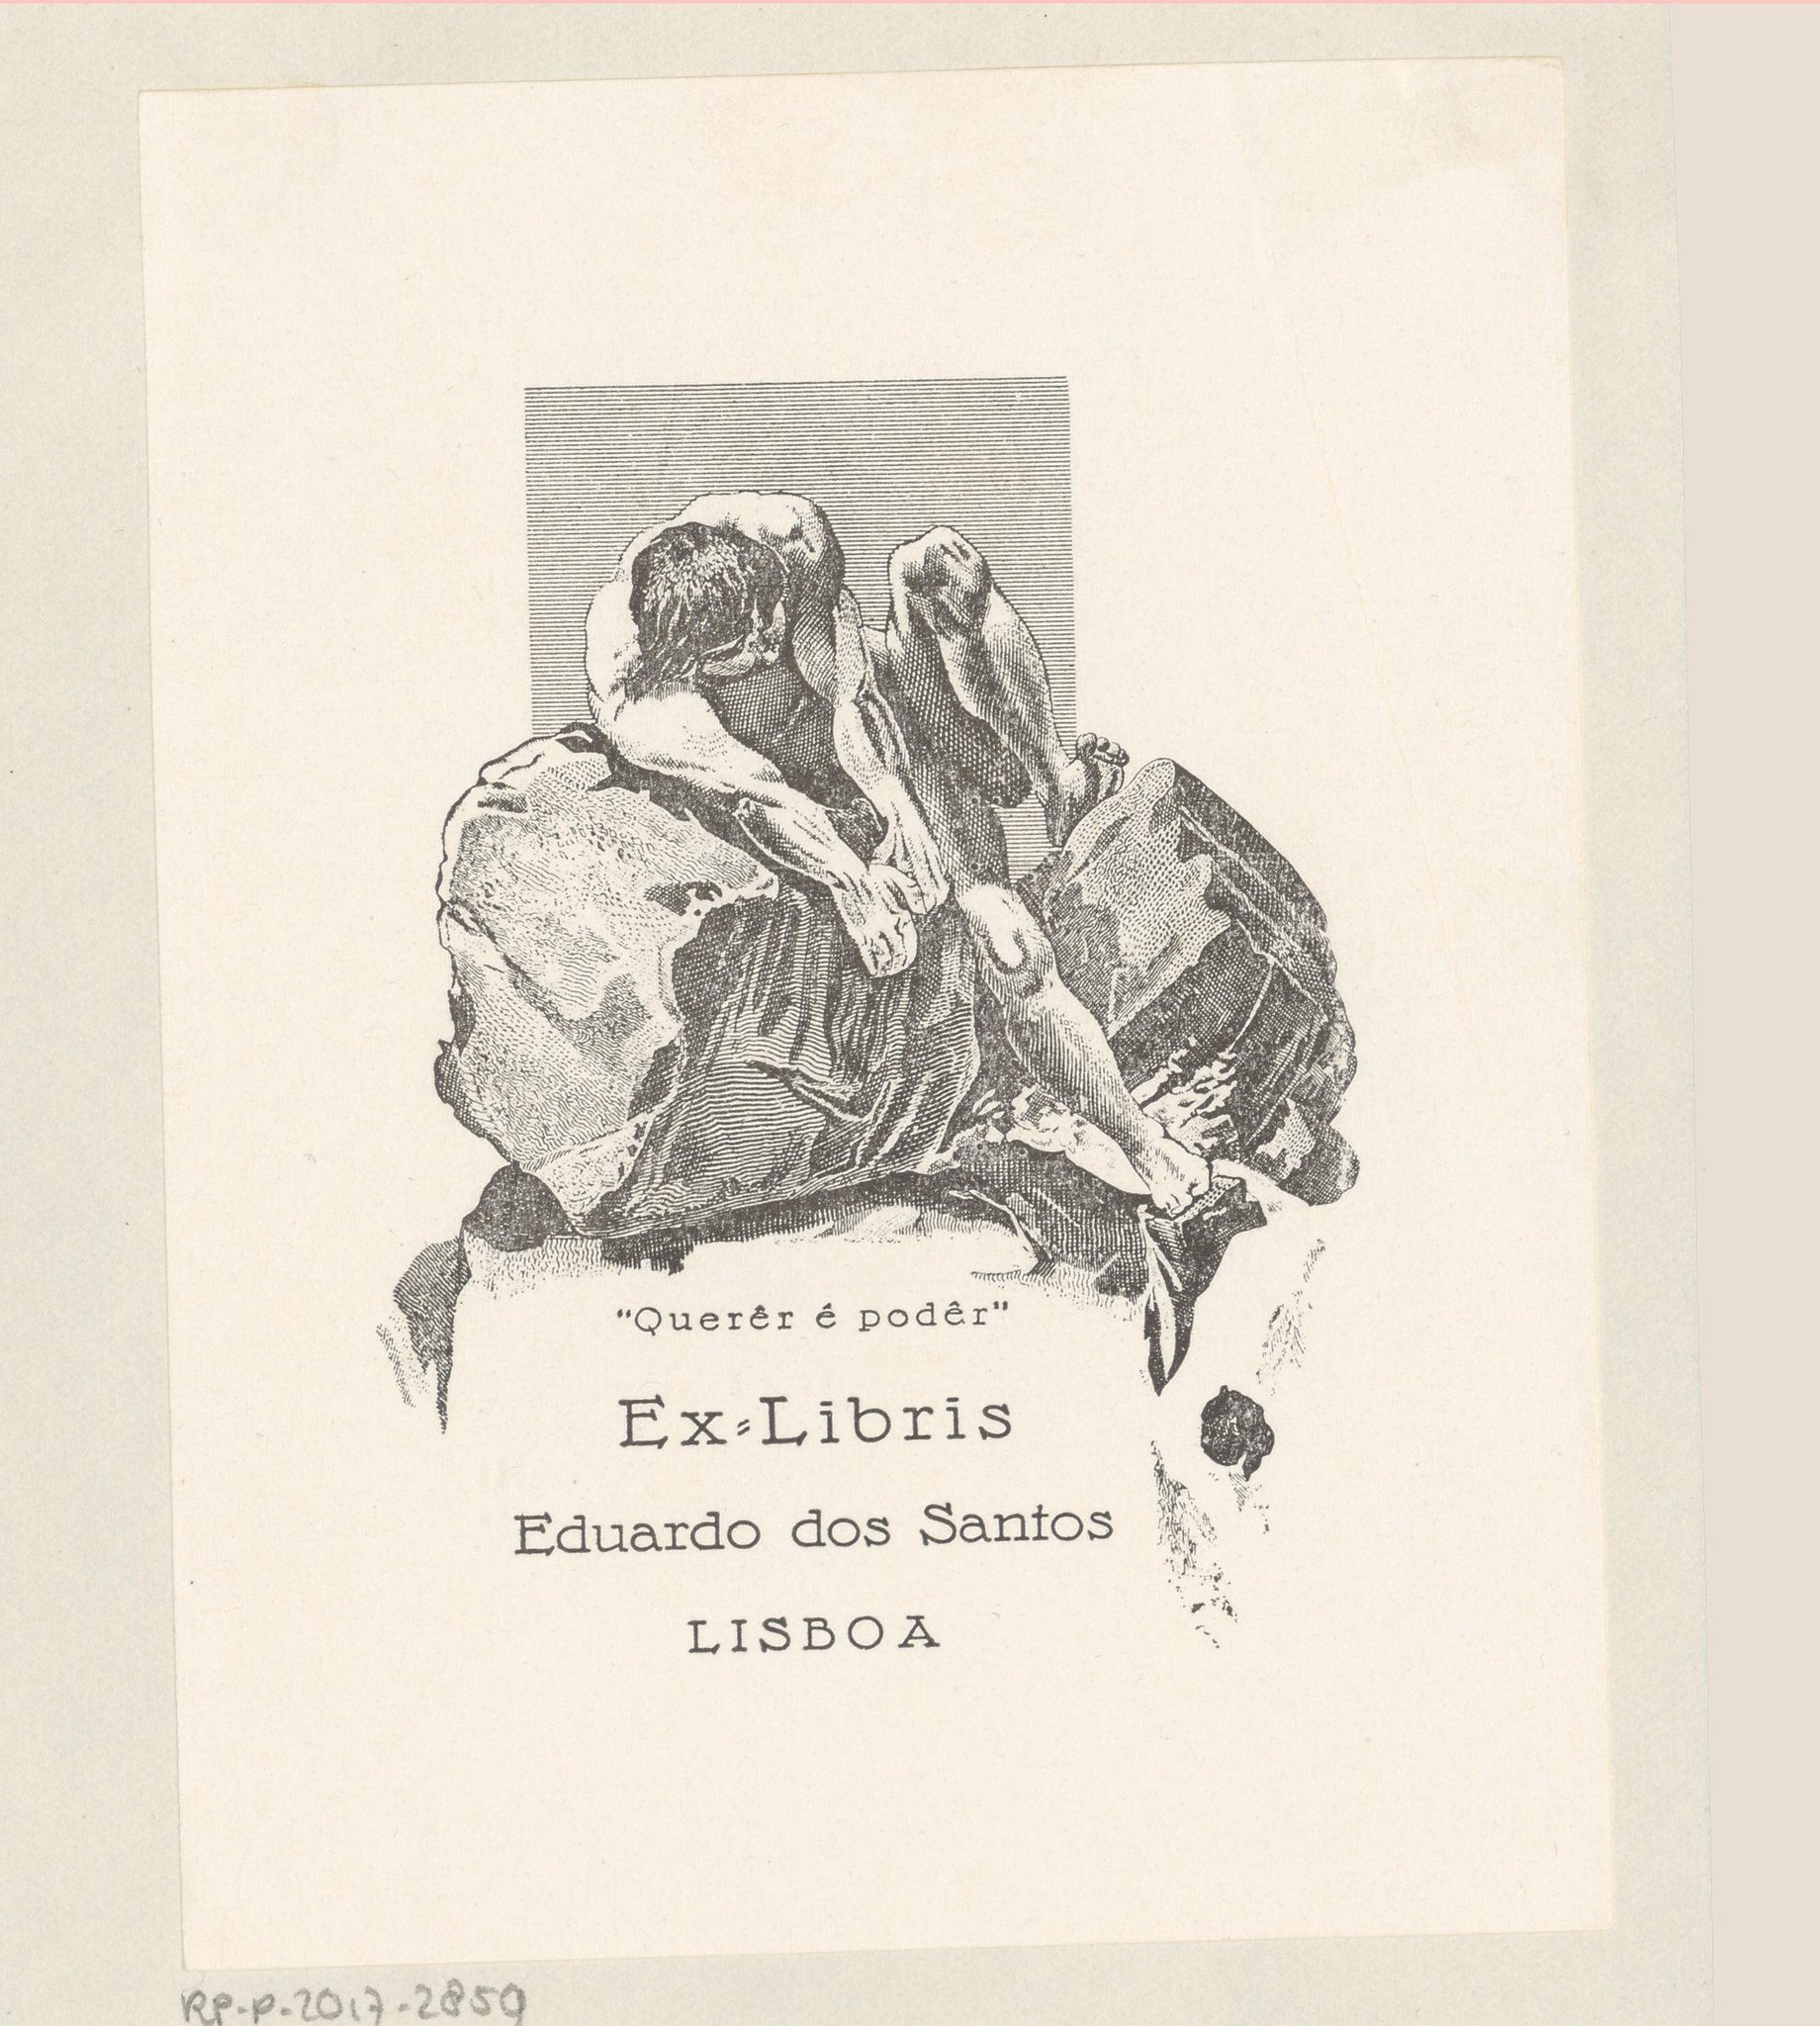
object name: bookplate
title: Ex libris van Eduardo dos Santos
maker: Anonymous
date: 1932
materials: paper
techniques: printing block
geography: portugal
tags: battle of the giants against the gods: gigantomachy, rocks, man (showing himself) undressed, quasi-nude